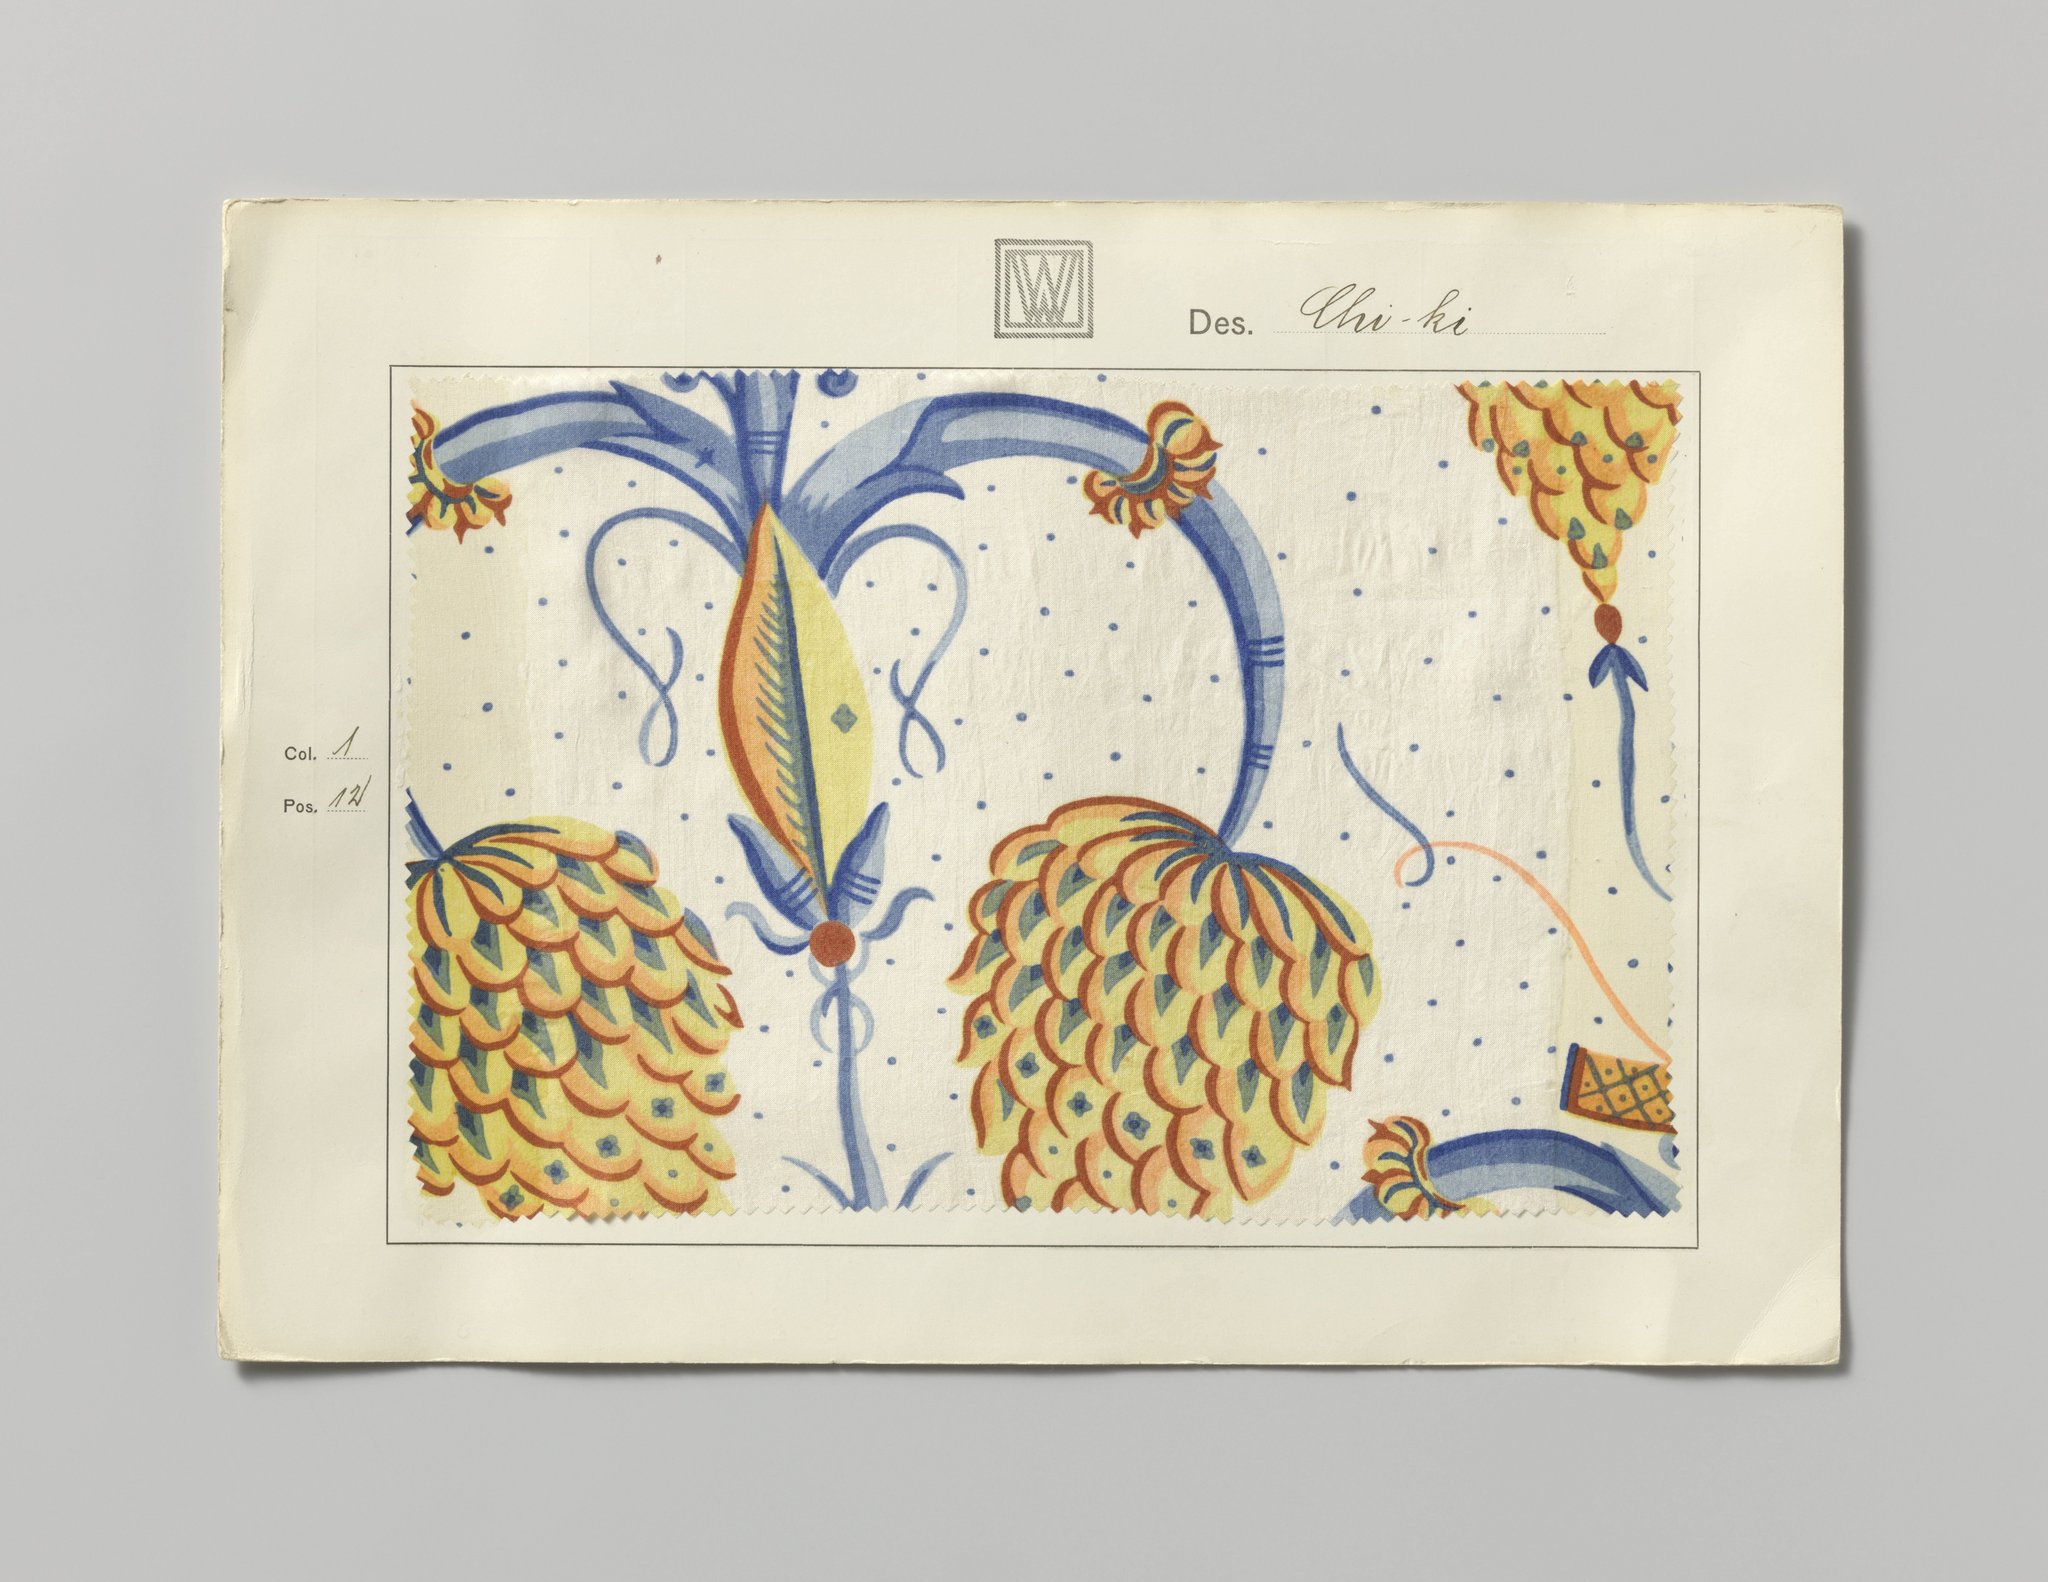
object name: sample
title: Staal met bedrukte zijde, dessin Chi-ki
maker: anny schröder-ehrenfest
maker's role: painter, textile artist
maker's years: 1898-1972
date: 1920-1921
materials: cardboard, silk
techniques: printing block, weave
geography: vienna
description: Staal met bedrukte zijde. Dessin Chi-ki, WW nr. 00720. Op naturel fond met blauwe stippen een dessin van gestileerde bloem- of vruchtvormen en ranken in twee tinten blauw, geel, zalm, roodbruin en groen. De staal is op karton gelijmd waarop het vignet van de Wiener Werkstätte. Op de achterzijde twee kleurvarianten met respectievelijk een roze en een beige fond.